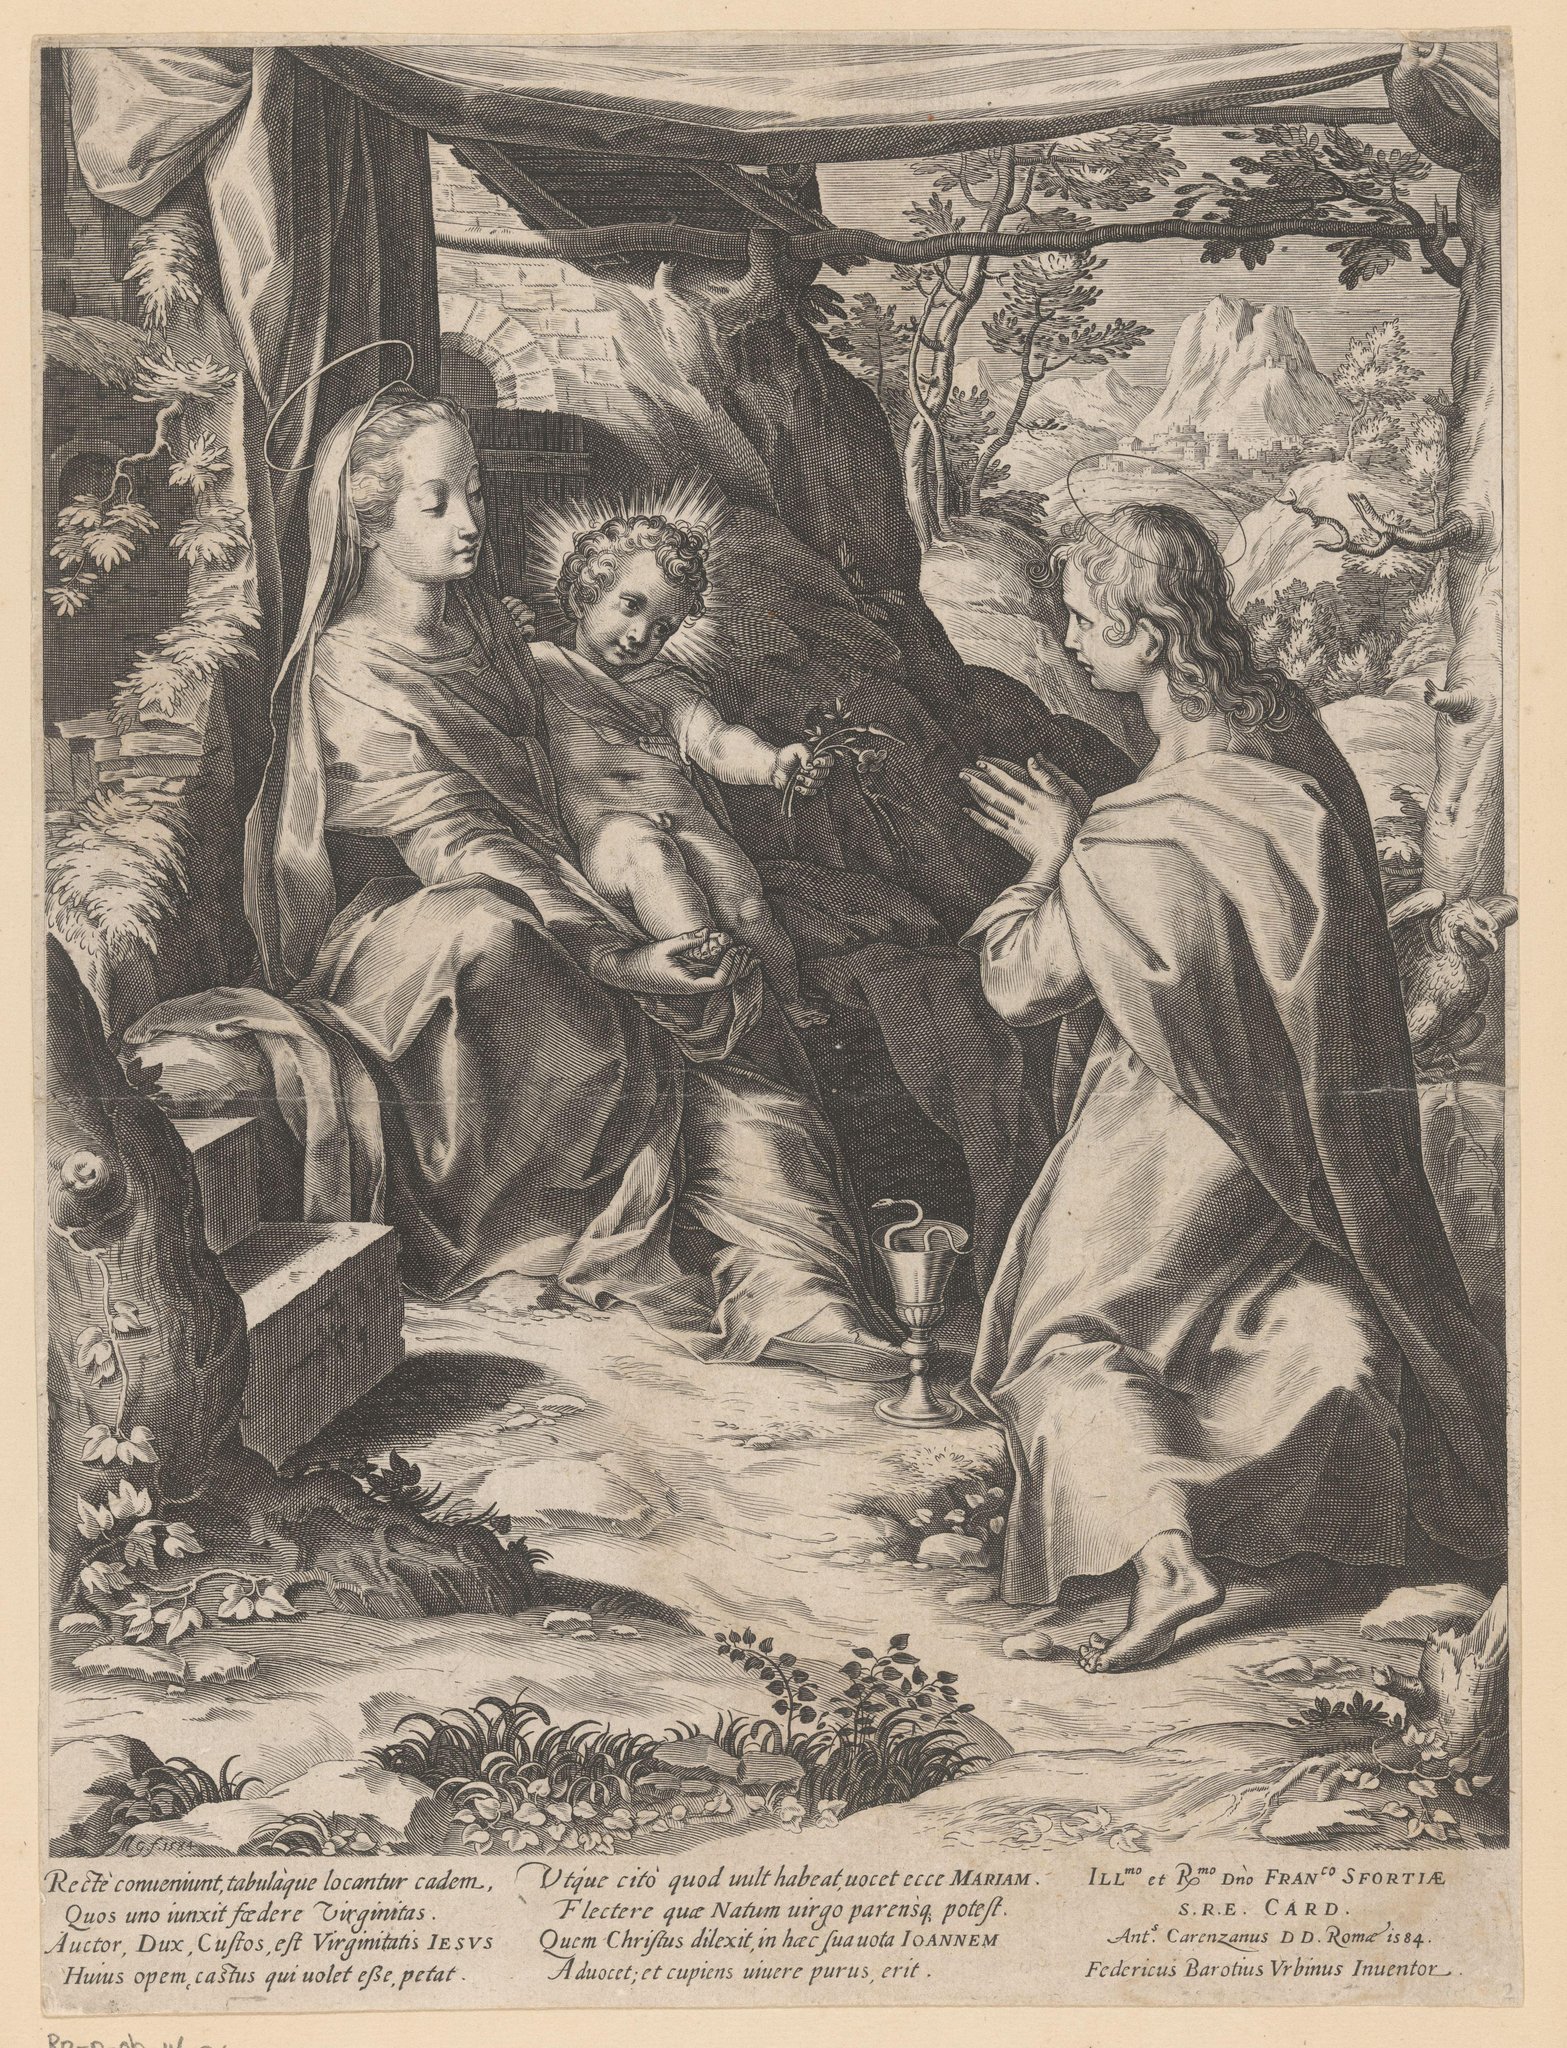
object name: print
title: Maria en kind aanbeden door Johannes de Evangelist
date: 1584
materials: paper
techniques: engraving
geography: rome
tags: madonna: i.e. mary with the christ-child, life and acts of john the evangelist, mountains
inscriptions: collector's mark: Lugt 240